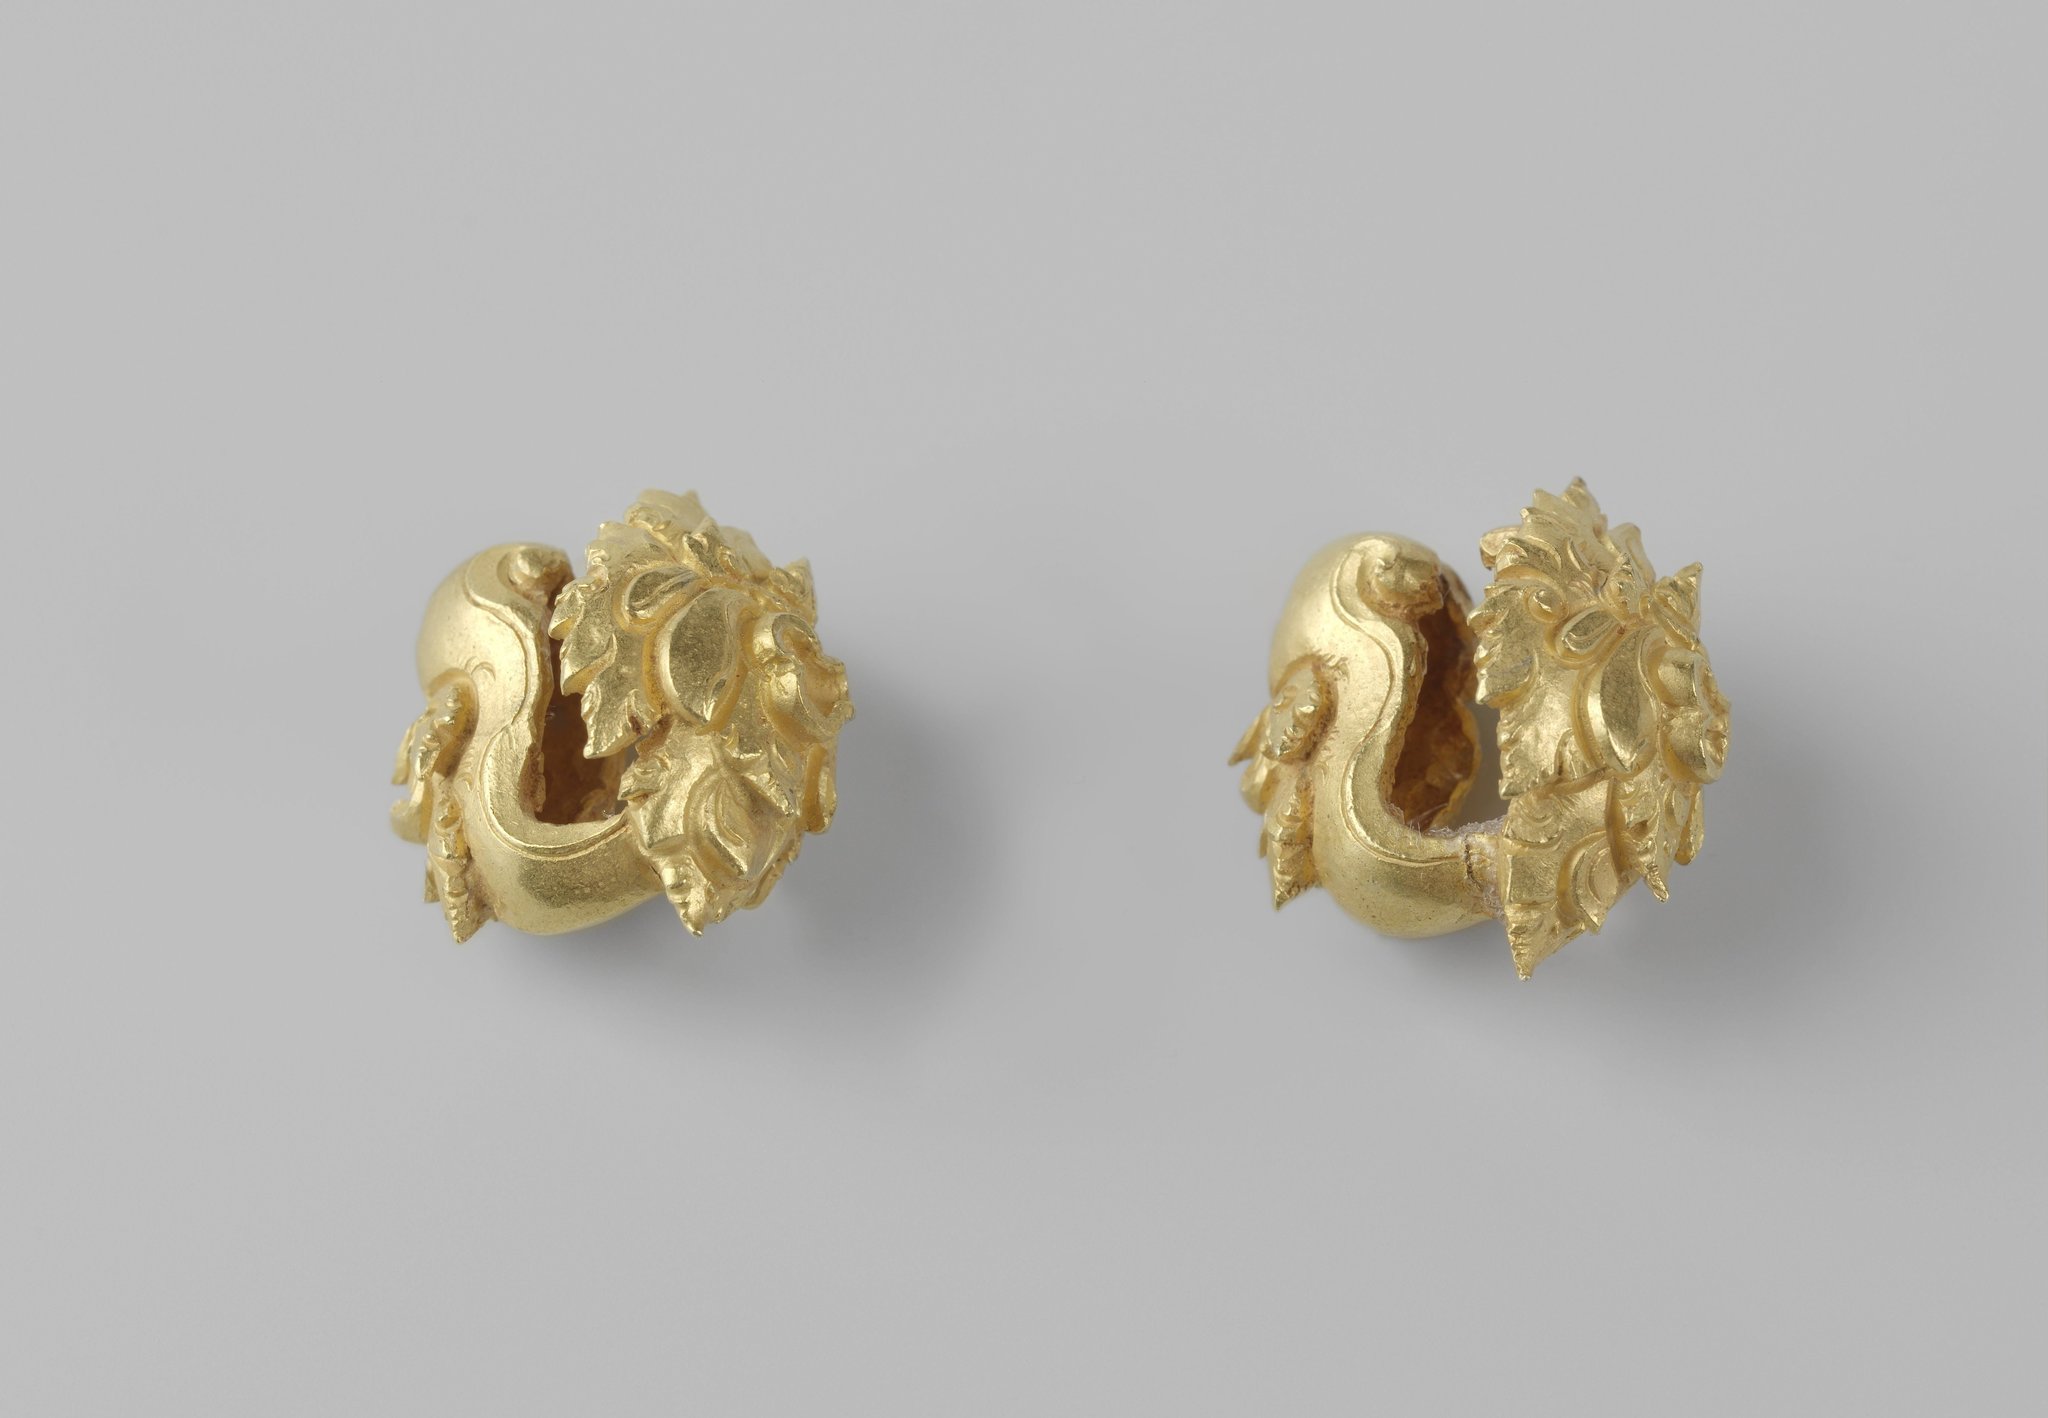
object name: ear ornament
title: Oorhanger van goud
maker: Anonymous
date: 1045-1500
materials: gold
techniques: casting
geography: java